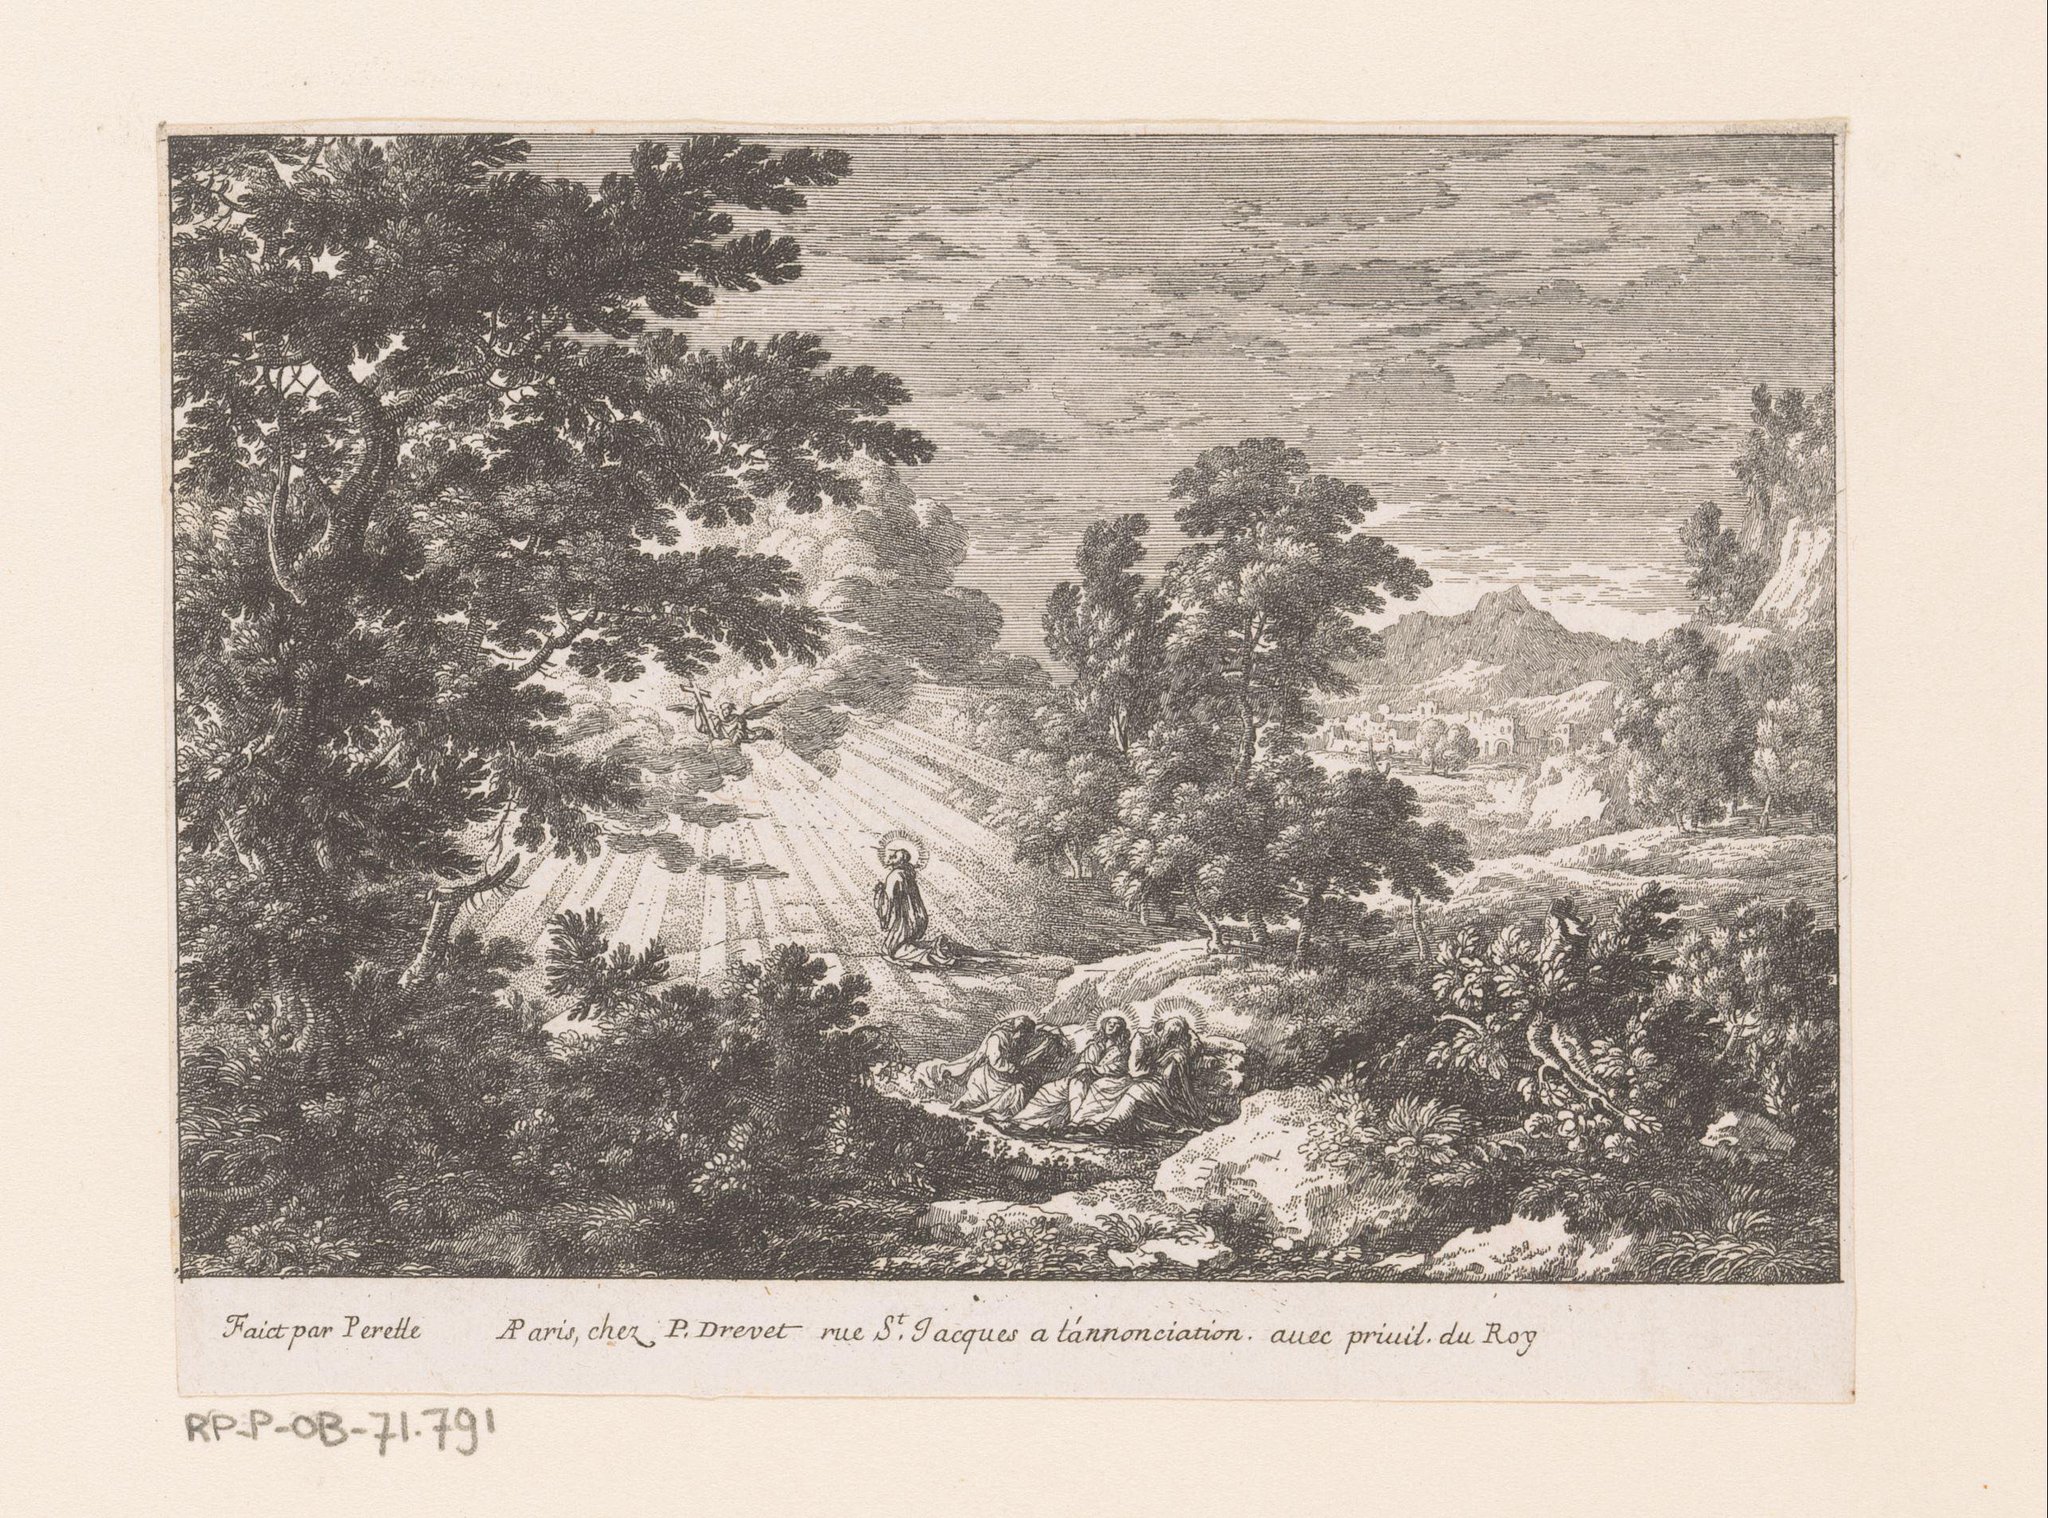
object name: print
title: Landschappen met Bijbelse voorstellingen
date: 1673-1695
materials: paper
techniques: etching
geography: paris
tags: landscapes, gethsemane, mount of olives, 'oelberg' (matthew 26:36-56; mark 14:32-52; luke 22:39-53; john 18:1-12)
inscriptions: collector's mark: Lugt 240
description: Prent maakt deel uit van een ongenummerde serie van zes prenten.